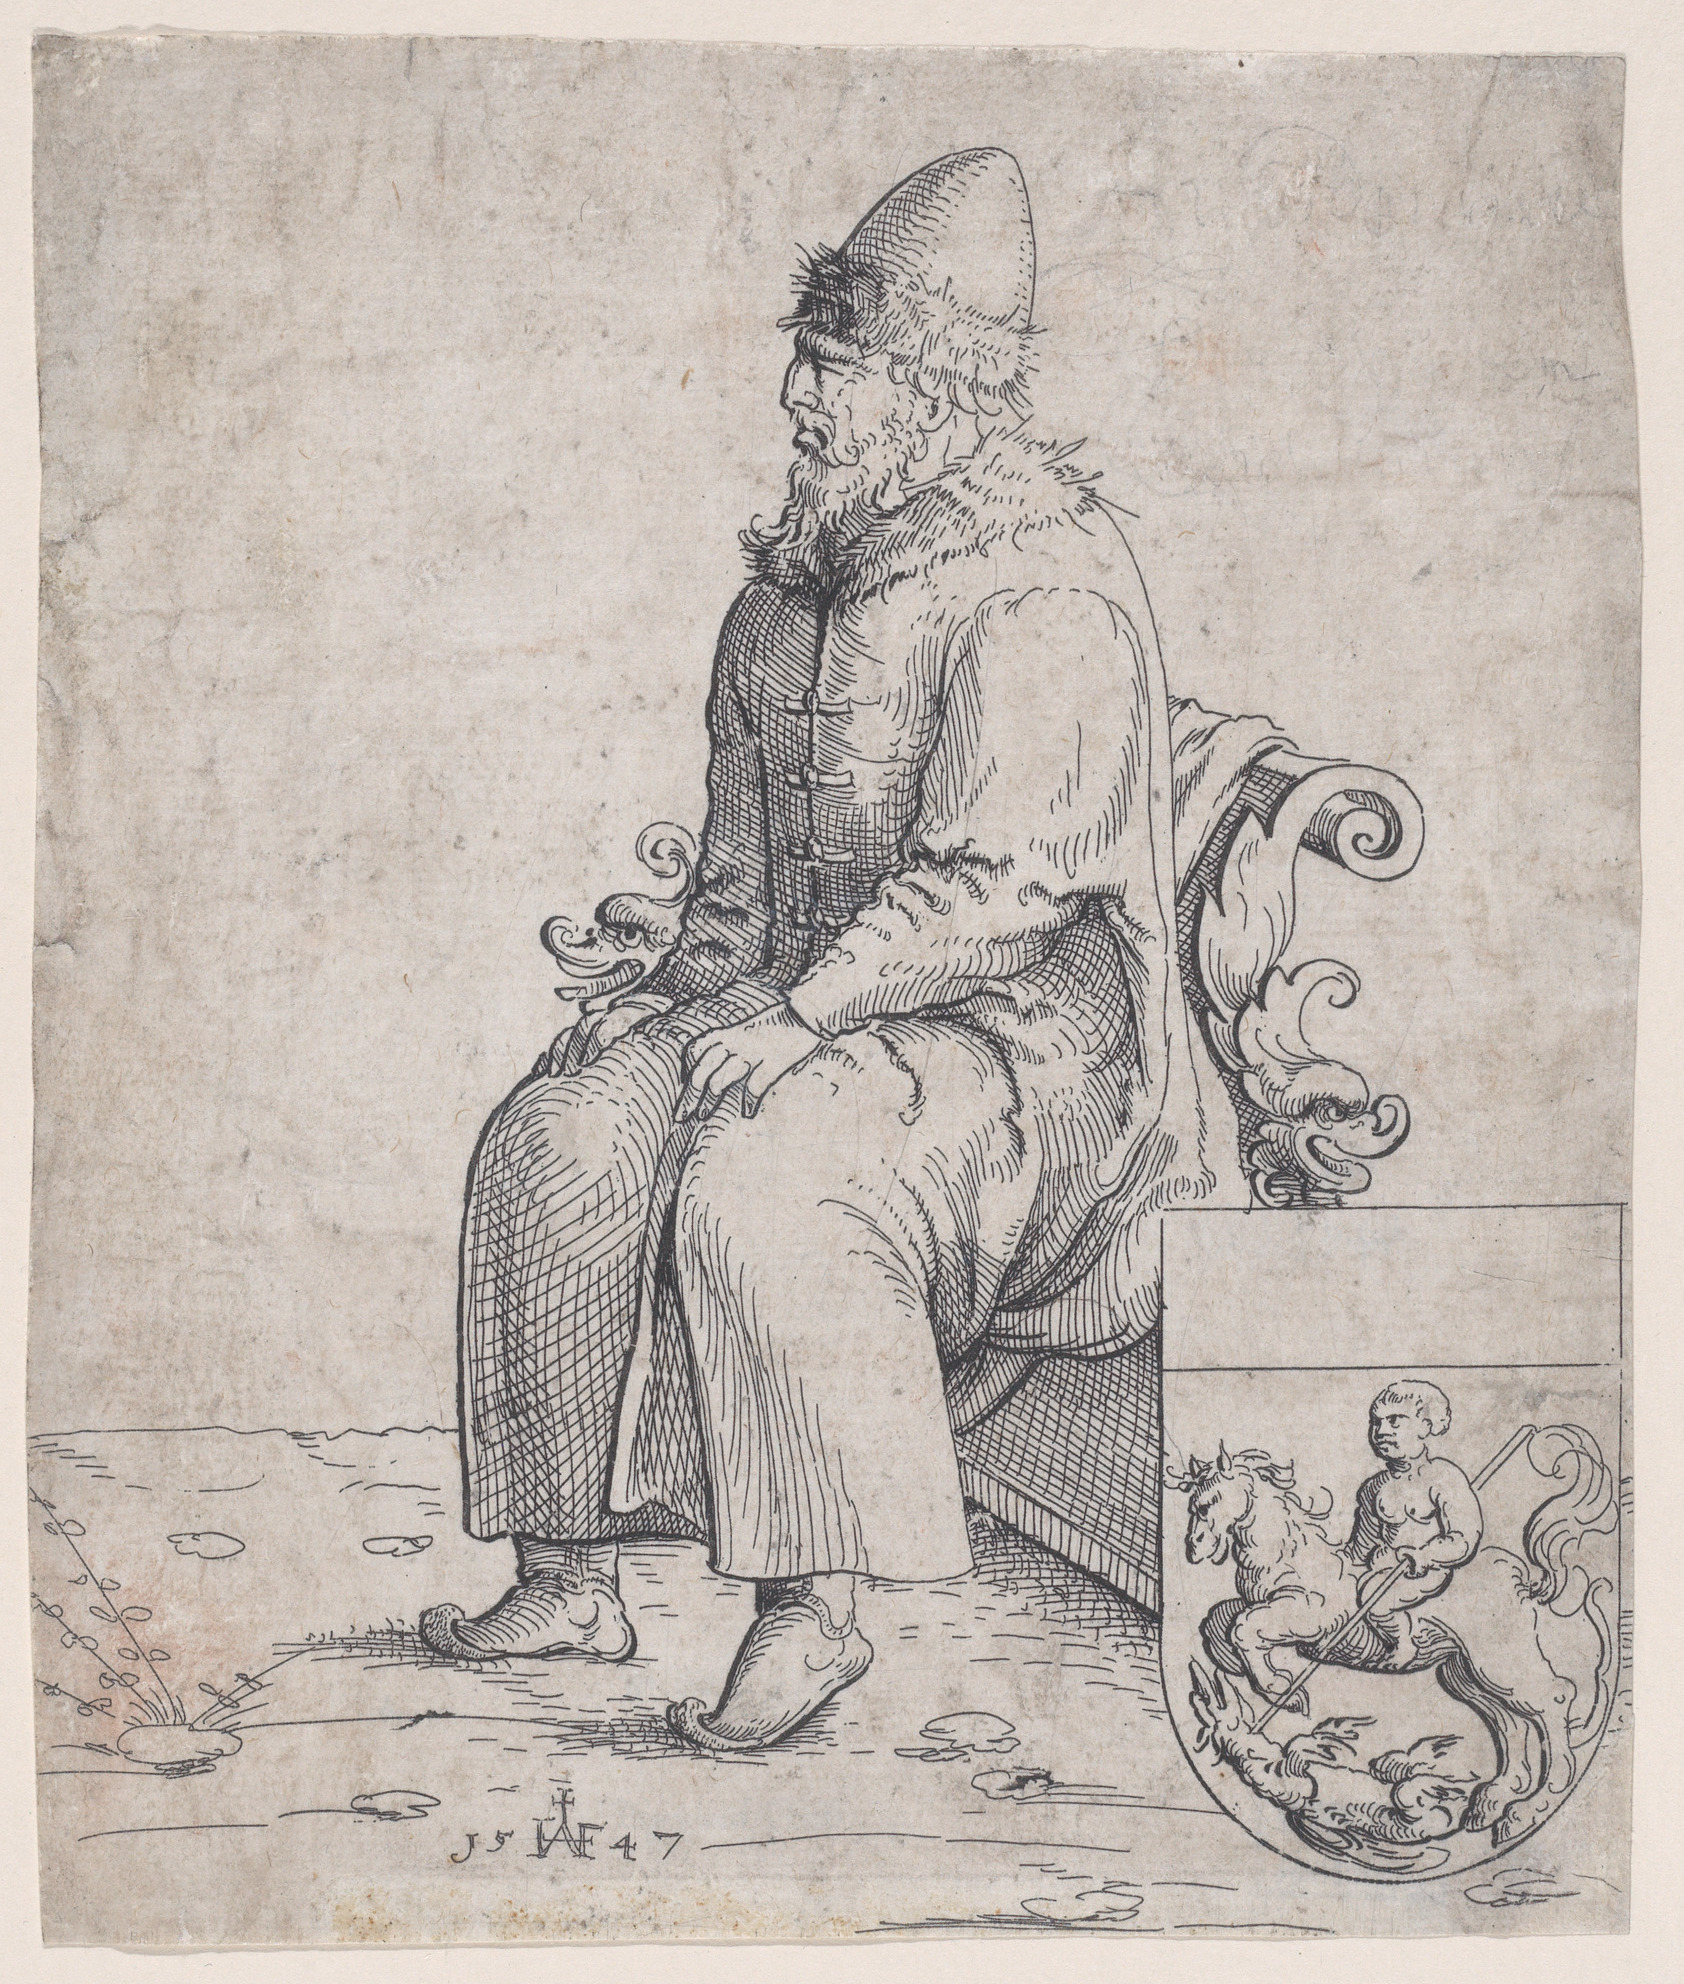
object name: print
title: Basil (Basilius), Grand Duke of Russia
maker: augustin hirschvogel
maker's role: artist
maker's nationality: german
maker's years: 1503-1553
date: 1547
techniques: etching